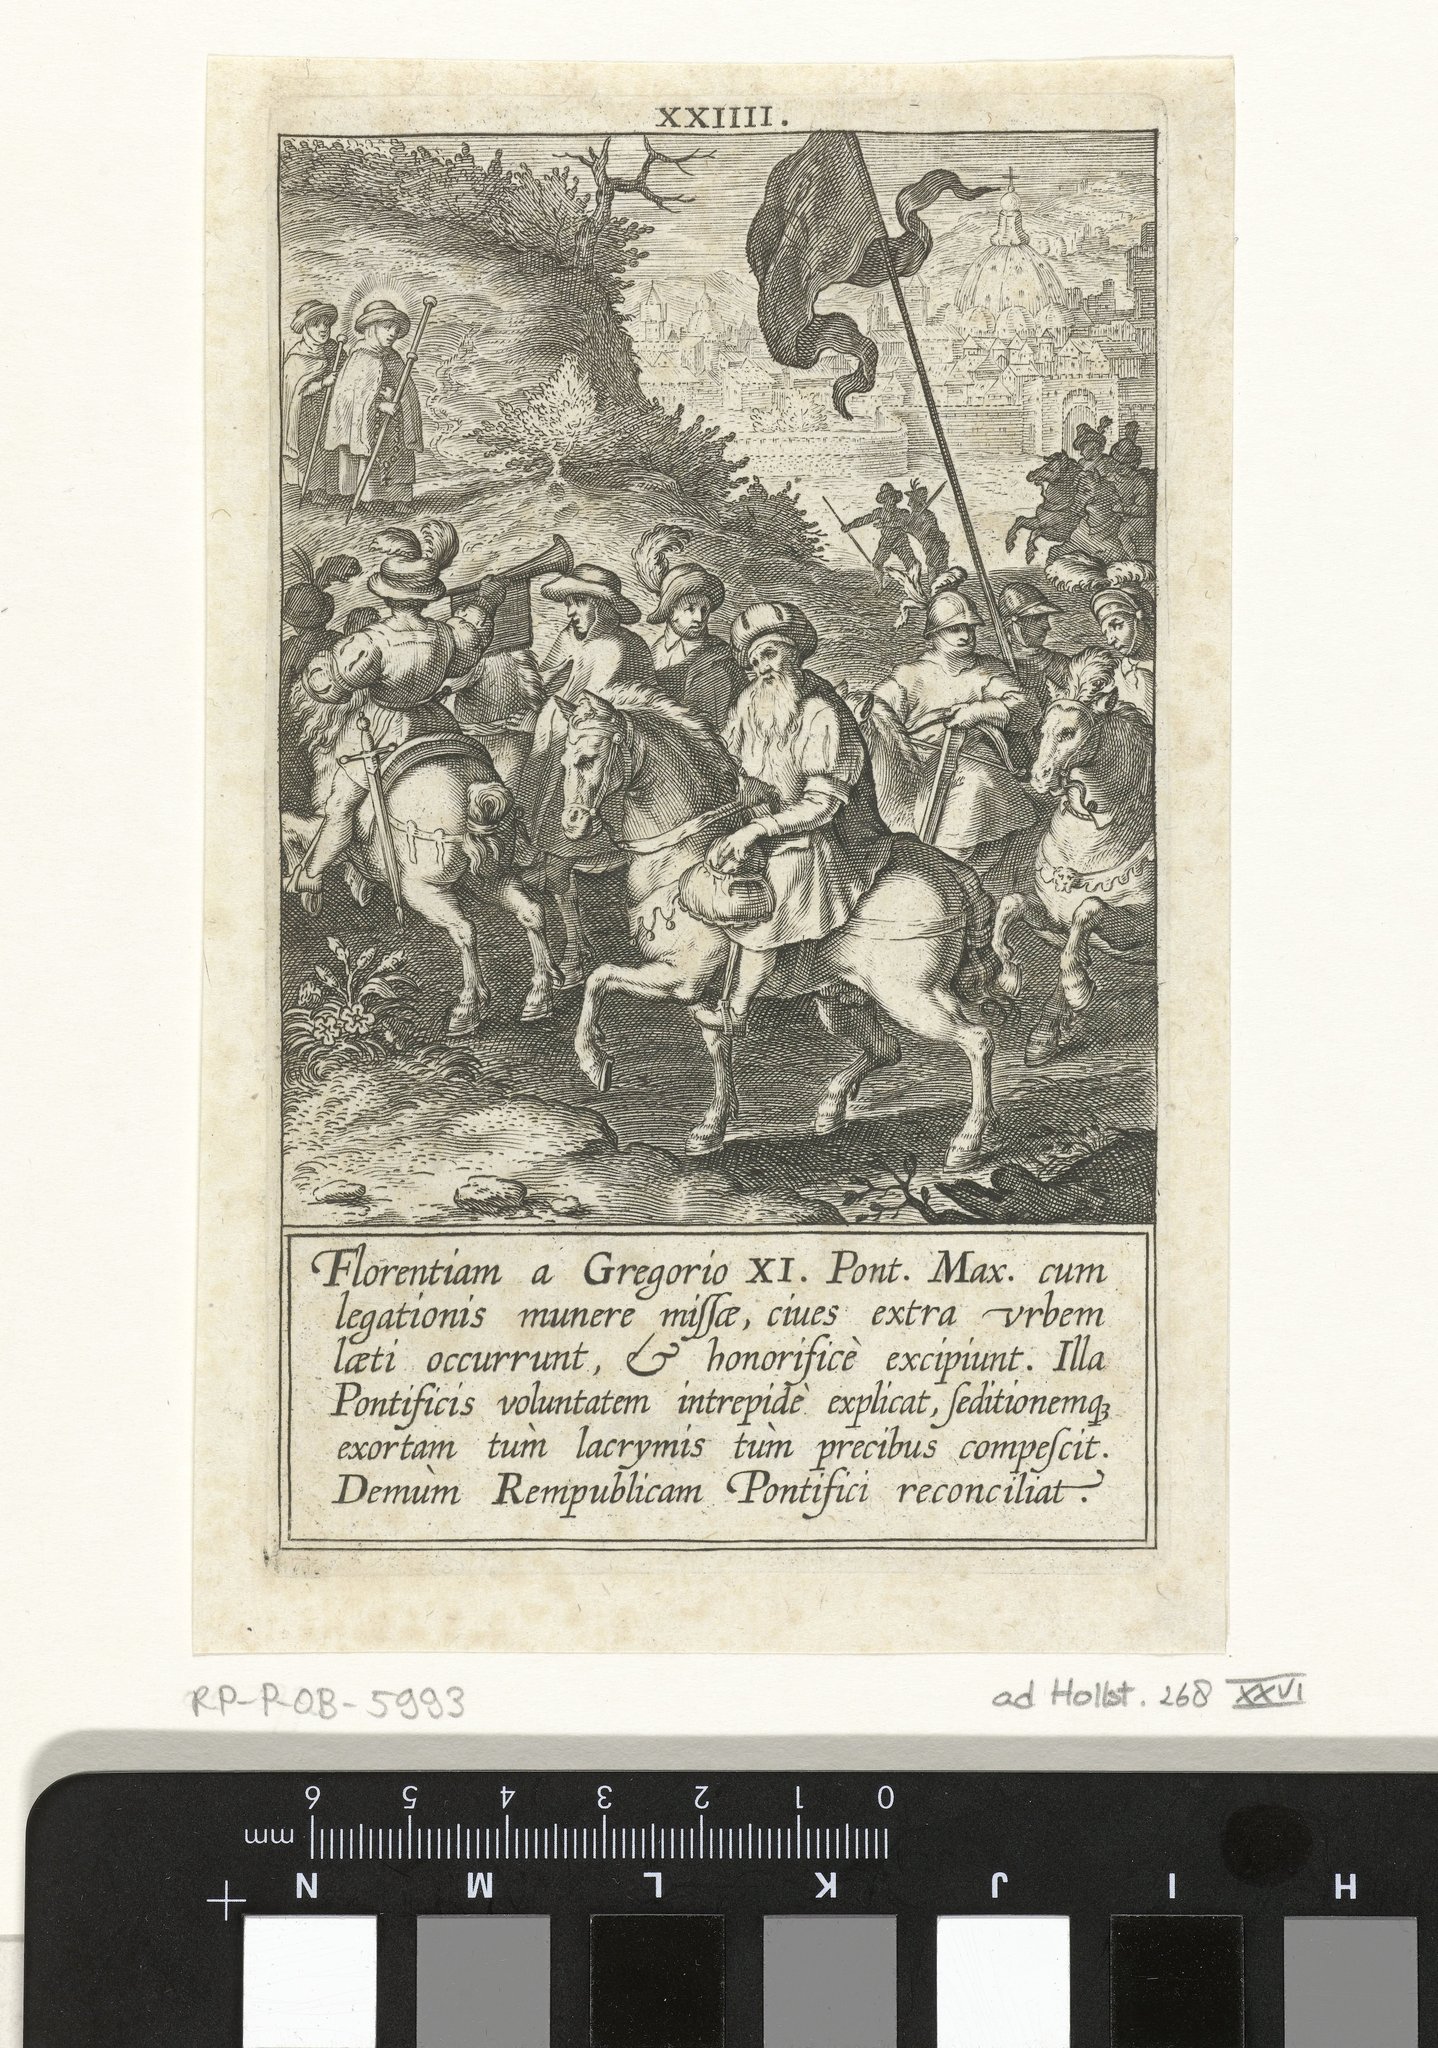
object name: print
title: Paus Gregorius XI keert terug naar Italië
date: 1603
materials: paper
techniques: engraving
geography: antwerp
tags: rome, pope gregory xi returns from avignon to rome after a visit from st. catherine of siena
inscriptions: collector's mark: Lugt 2228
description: Paus Gregorius XI keert met zijn gevolg terug naar het pauselijke hof in Italië. Onderweg komt hij Catharina en een andere dominicanes tegen. Deel van een serie over Catharina van Siena bestaande uit een titelprent, een portret en 32 genummerde scènes uit haar leven.